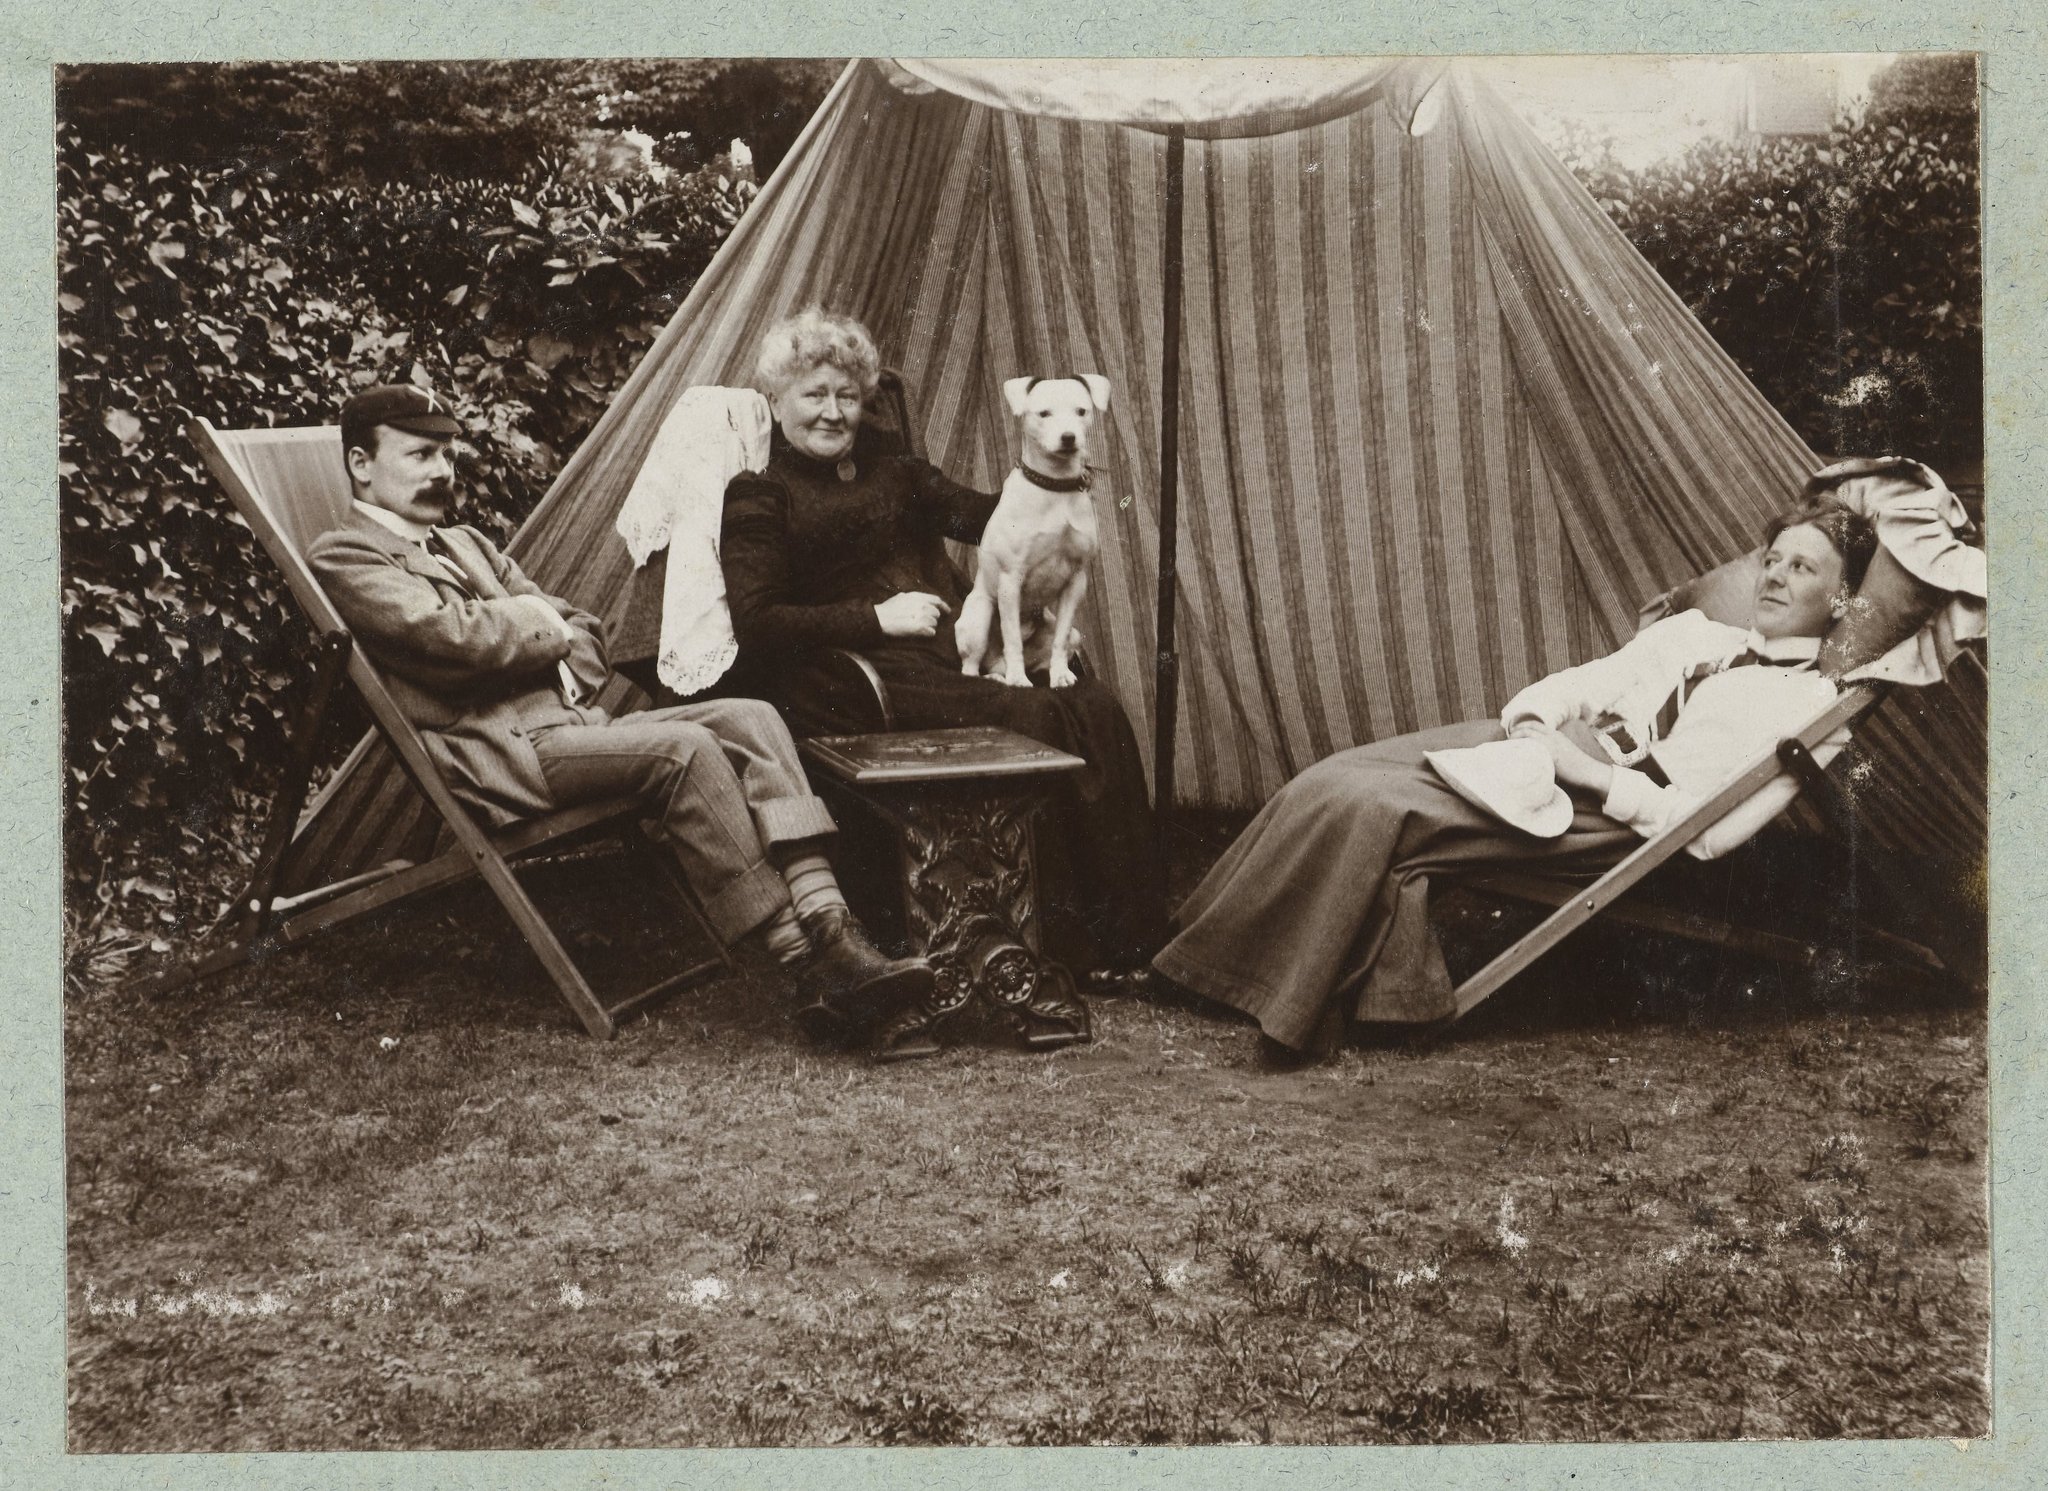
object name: photograph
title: Familieportret bij tent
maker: frits freerks fontein fz.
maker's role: fotograaf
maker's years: 1882-1928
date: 1901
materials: cardboard, paper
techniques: gelatin silver print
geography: netherlands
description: Twee vrouwen en een man zitten in strandstoelen voor een tent. Een vrouw heeft een witte hond op schoot. Foto uit album 'Photographieën".